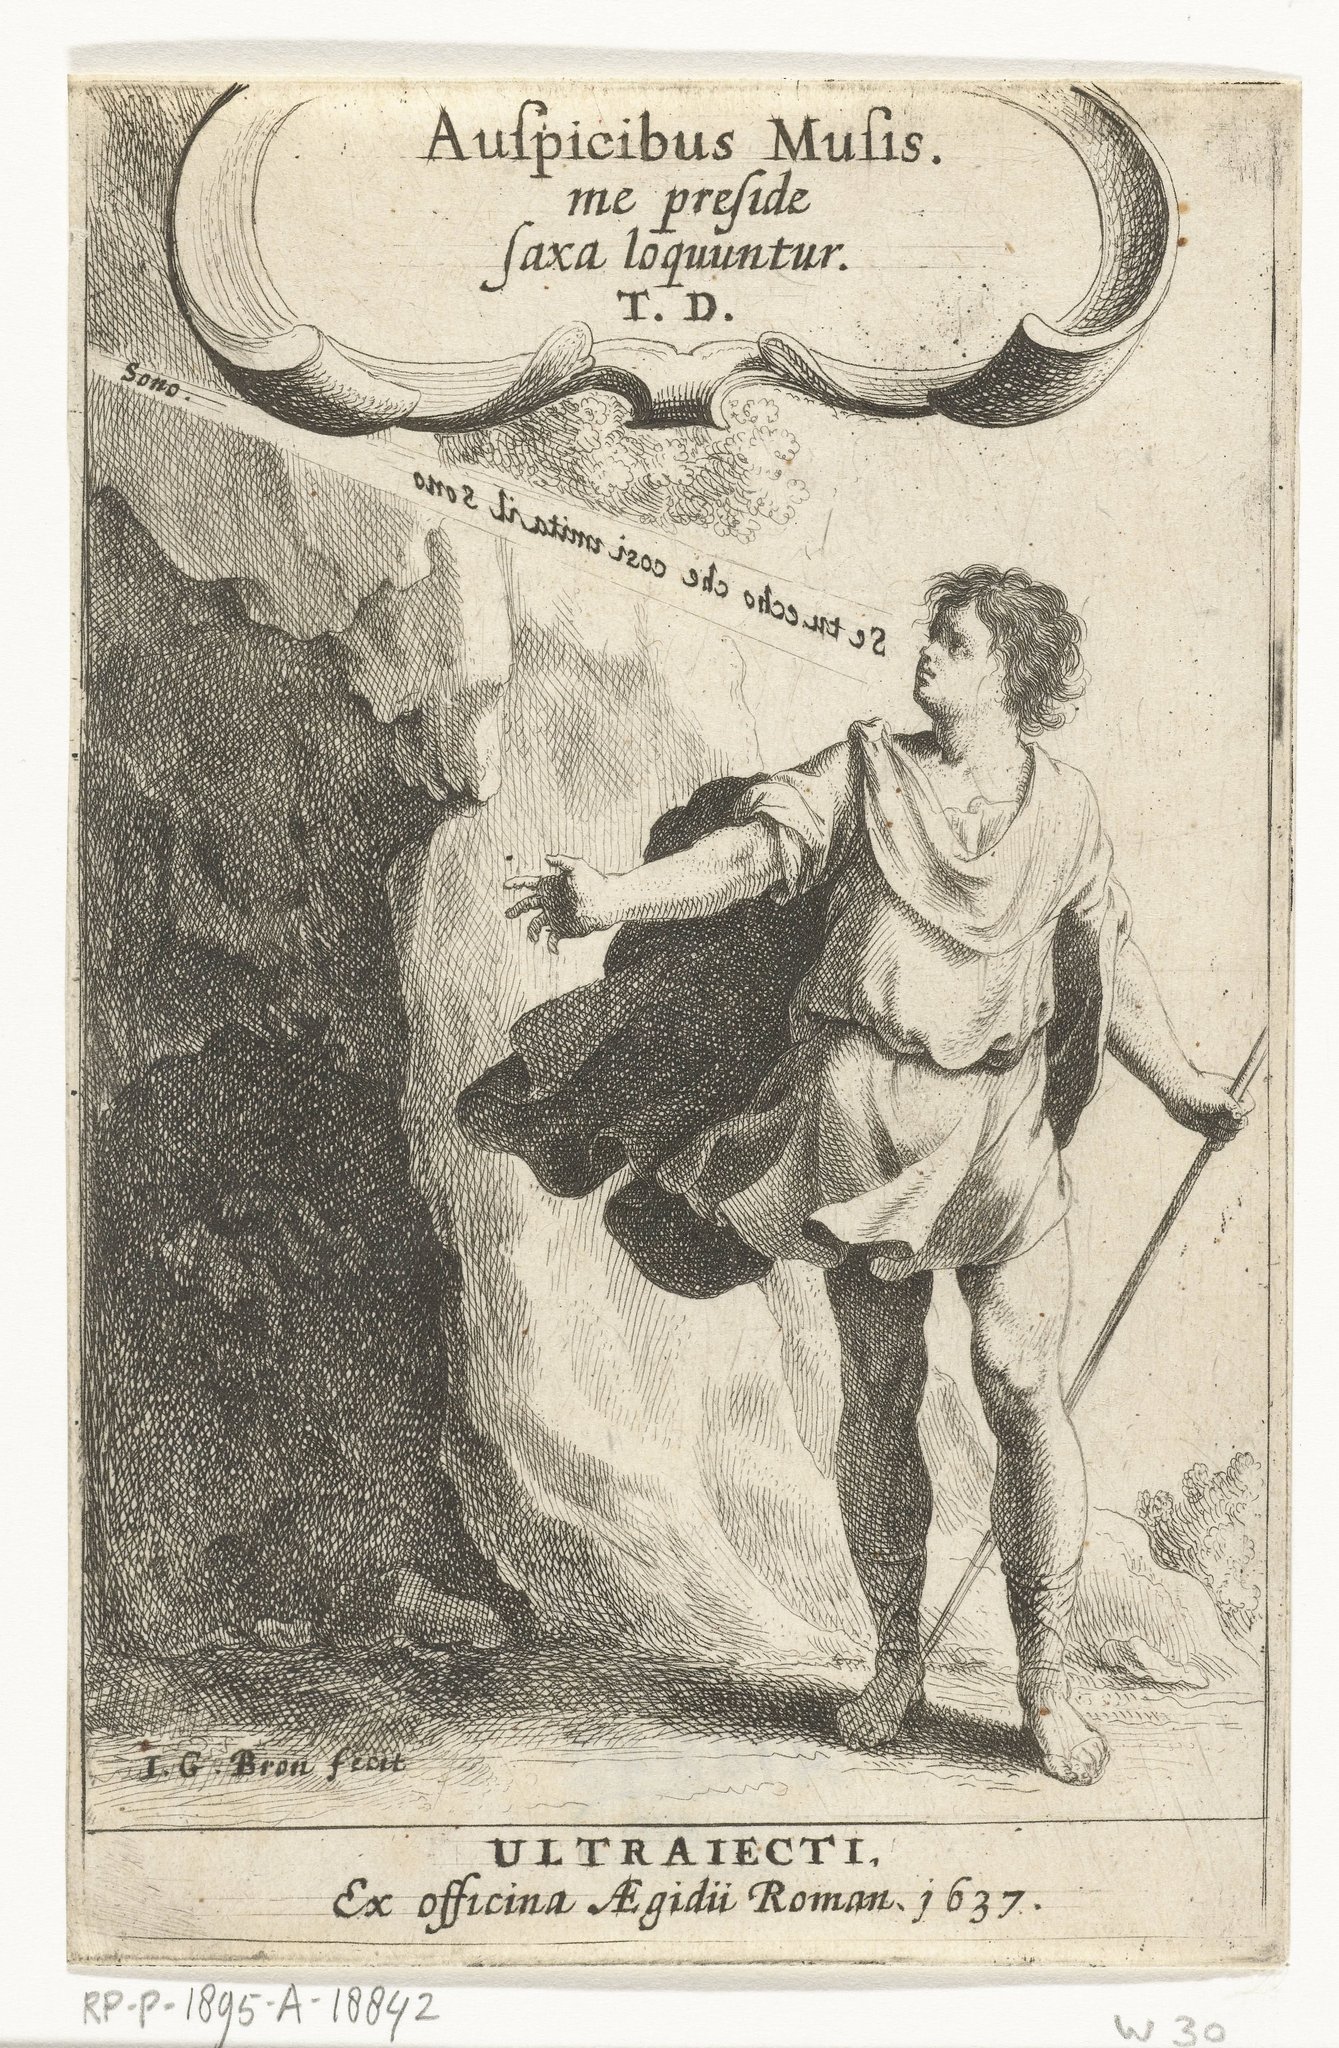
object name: print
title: Titelprent voor: Auspicibus Musis me preside saxa loguuntur, Utrecht 1637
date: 1637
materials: paper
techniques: etching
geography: utrecht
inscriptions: collector's mark: Lugt 2228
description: Een jongen met een stok wijst naar de opening van een grot. In een cartouche staat de tekst Auspicibus Musis me preside saxa loguuntur, met initialen van schrijver T.D..